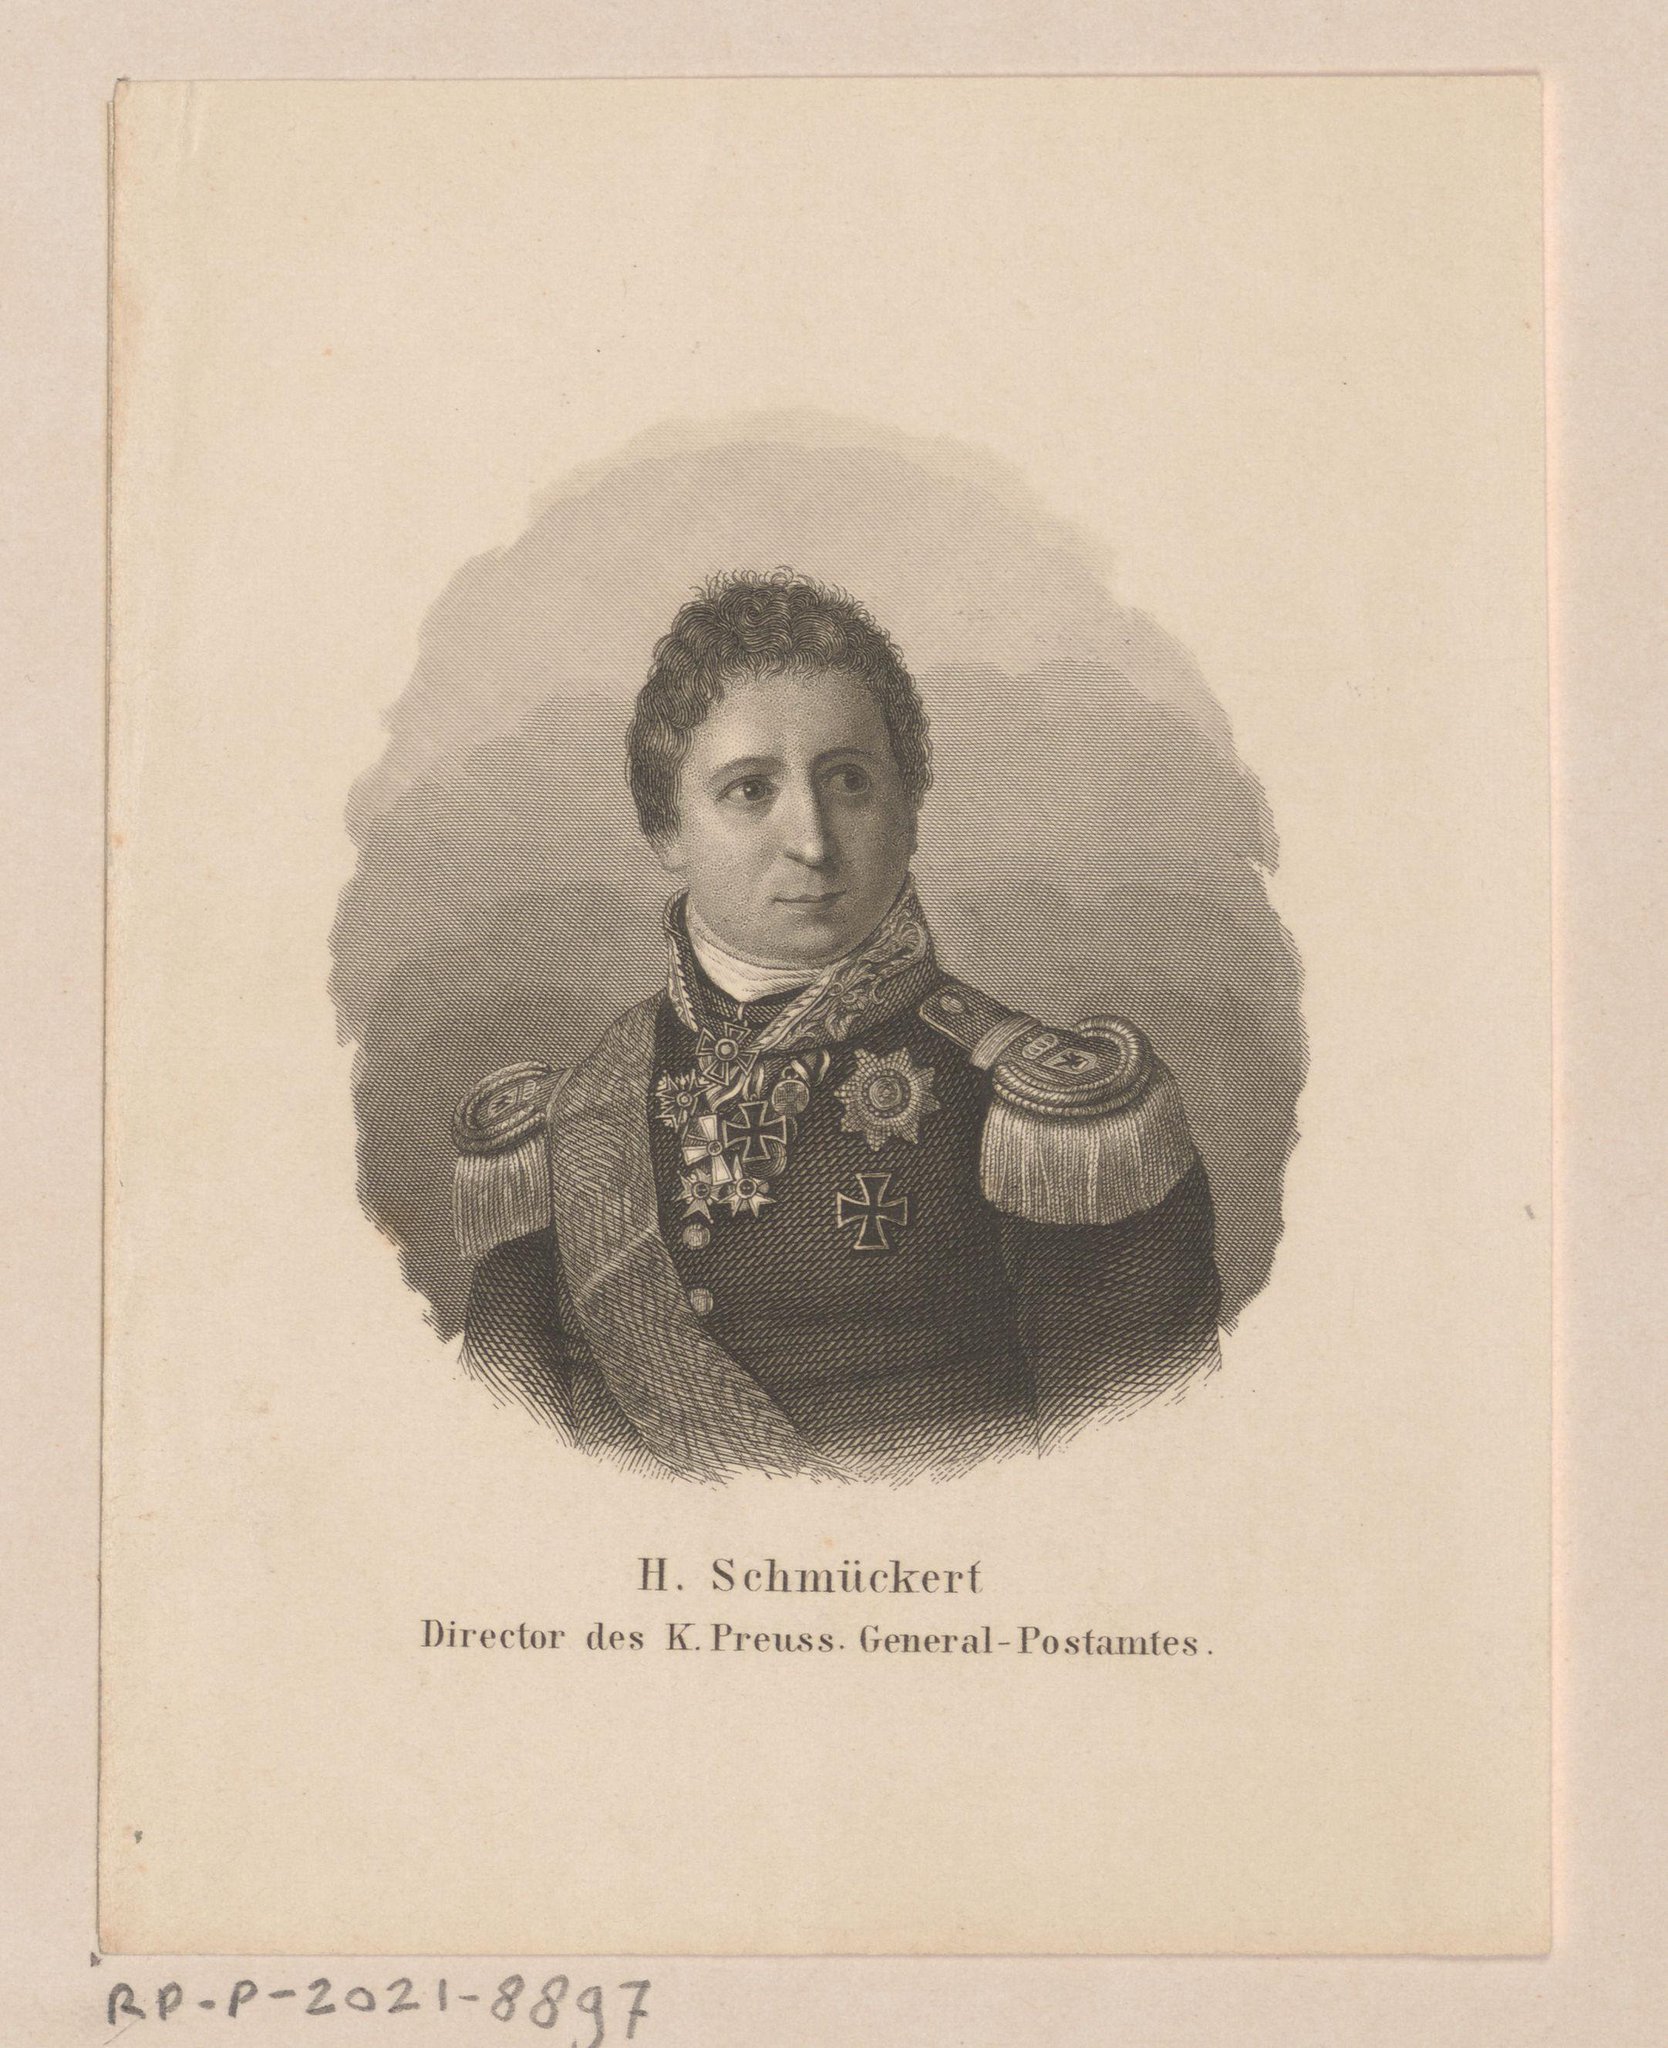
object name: print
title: Portret van Heinrich Schmückert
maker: Anonymous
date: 1846-1862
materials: paper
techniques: engraving, etching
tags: knighthood order, commander-in-chief, general, marshal, historical persons